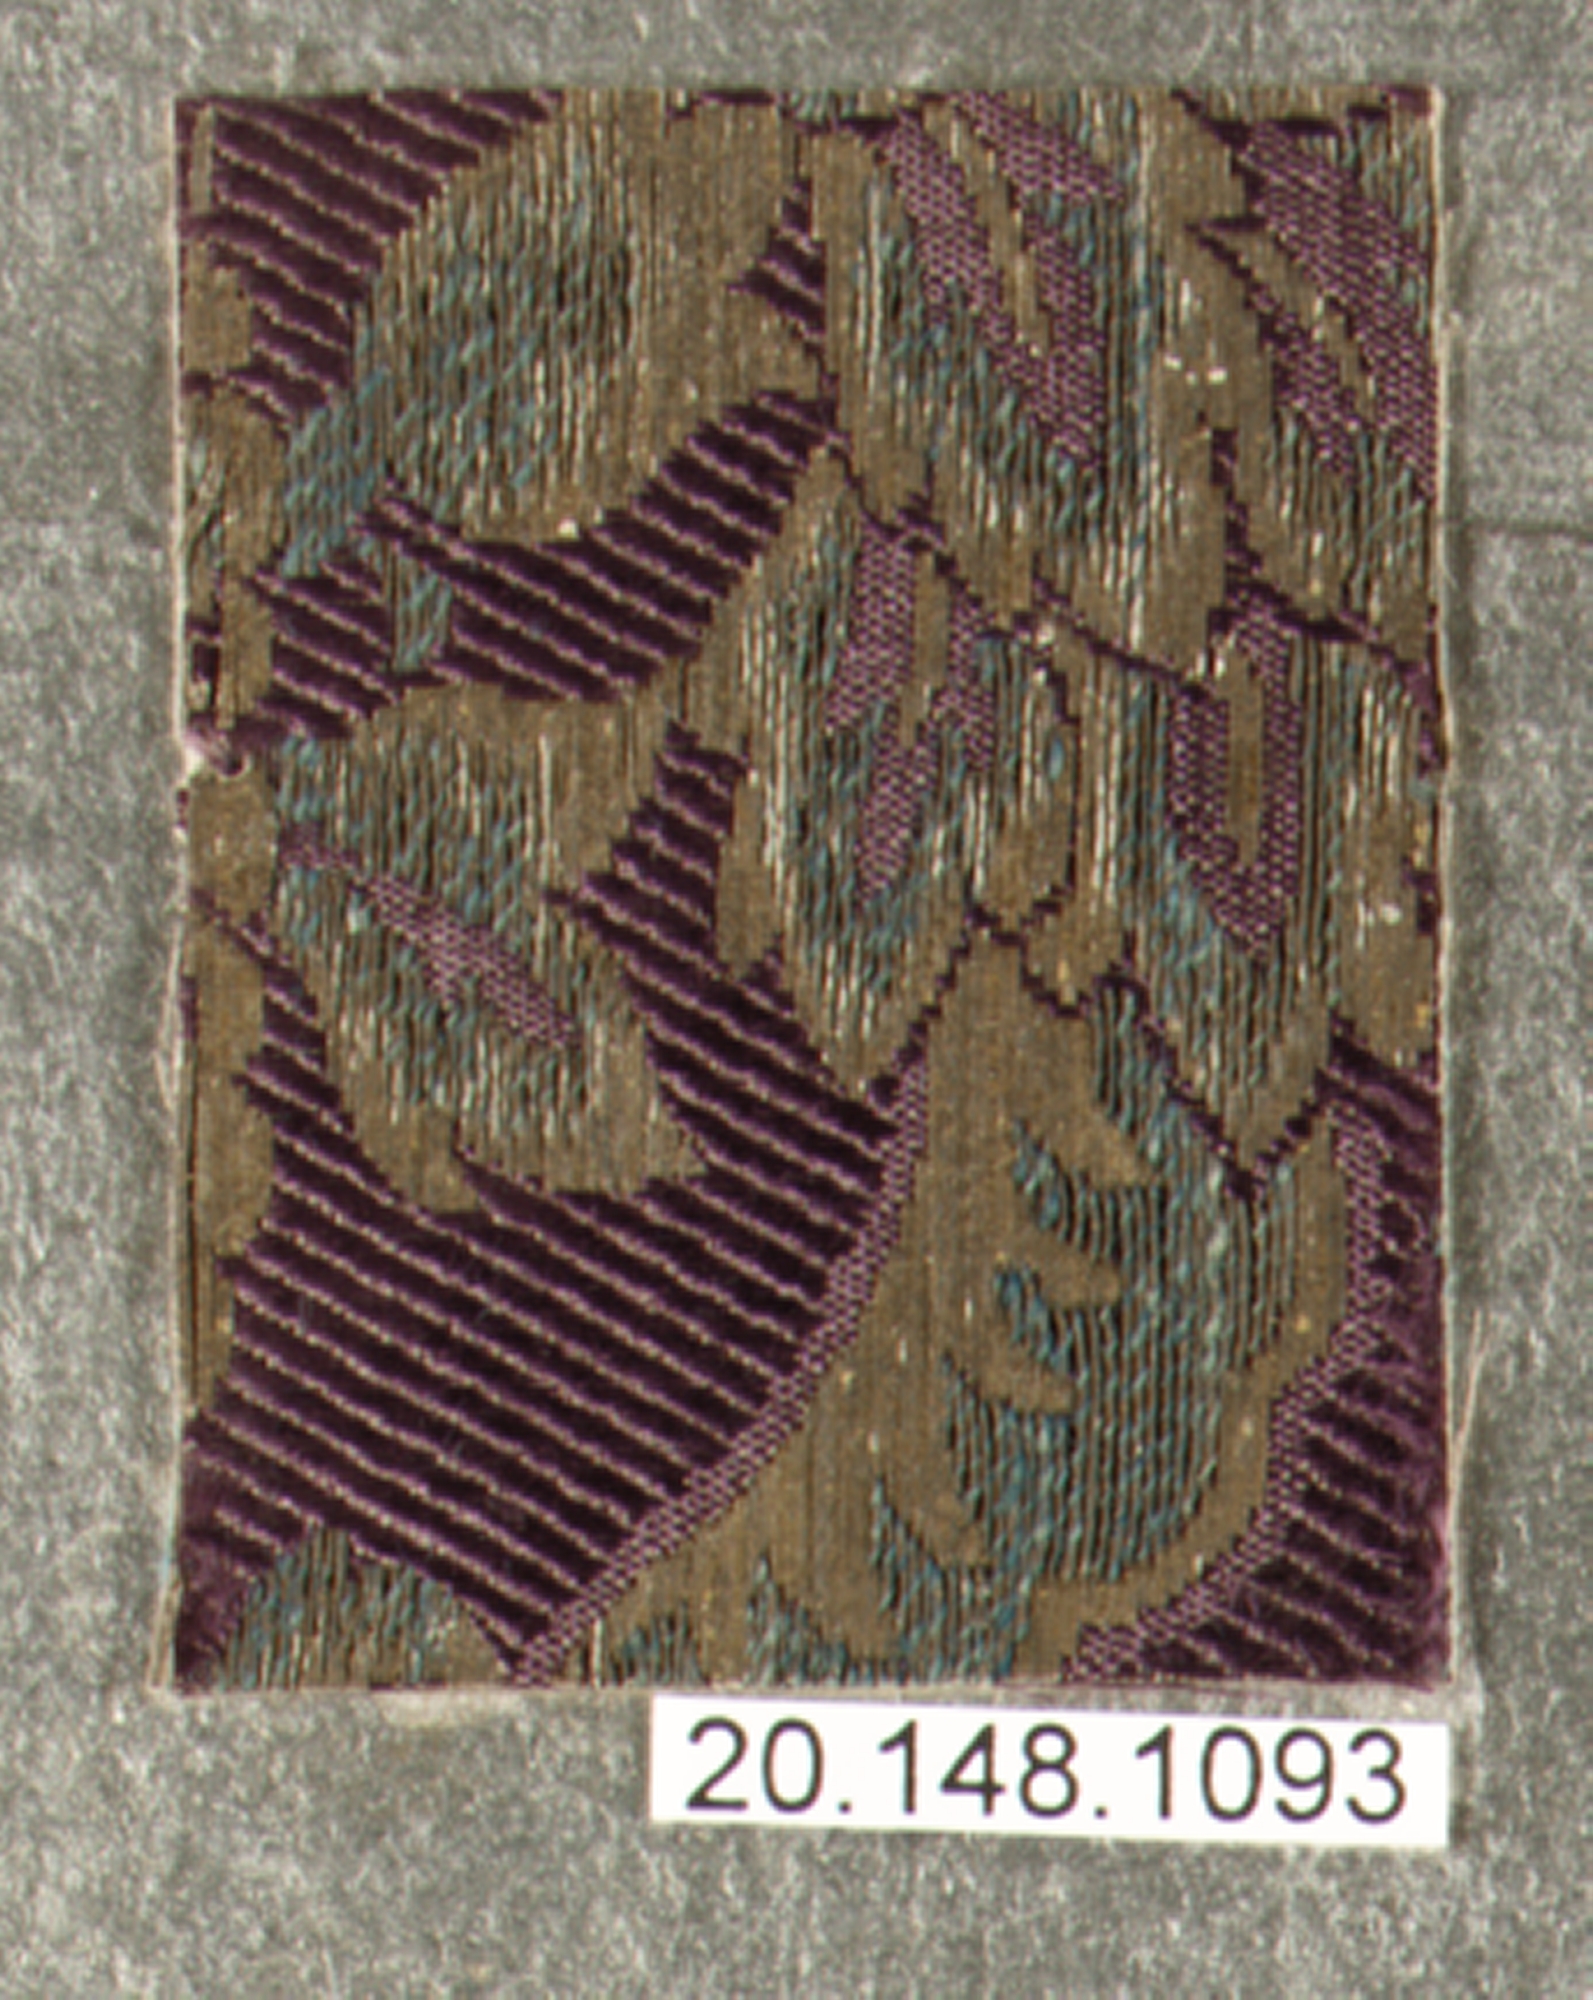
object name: piece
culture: japanese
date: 1701-1800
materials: silk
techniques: compound weave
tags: leaves